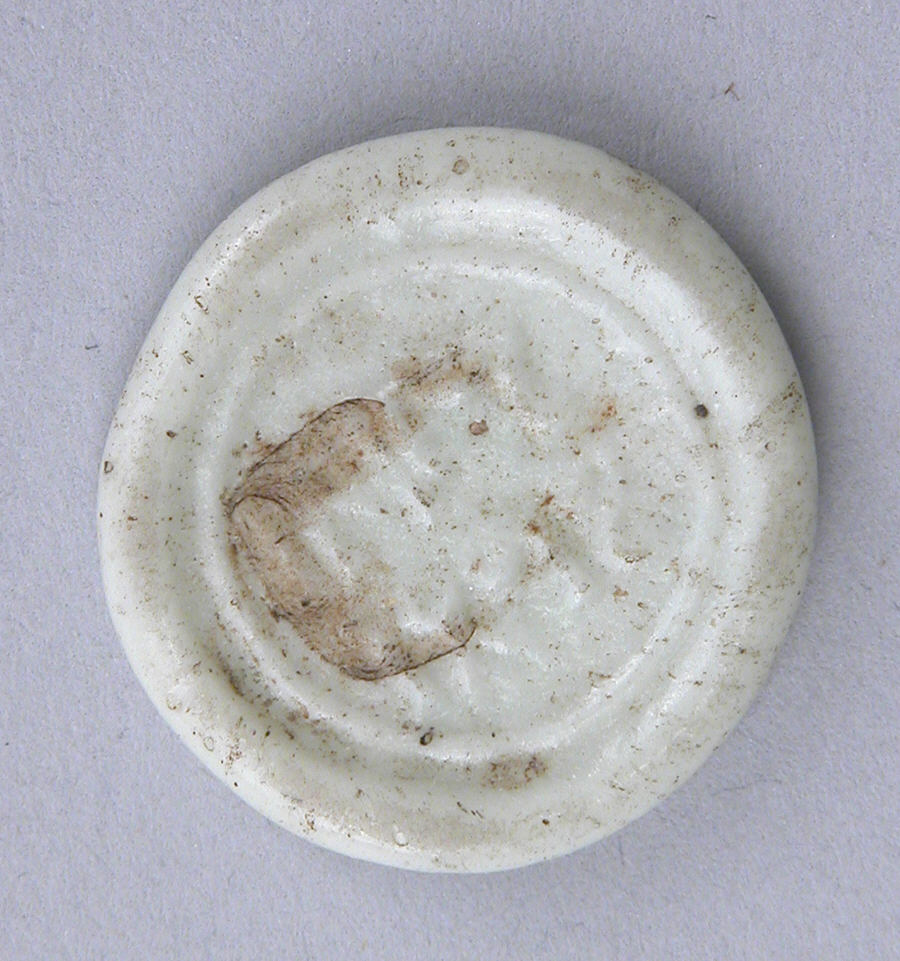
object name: coin weight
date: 1101-1200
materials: glass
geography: egypt